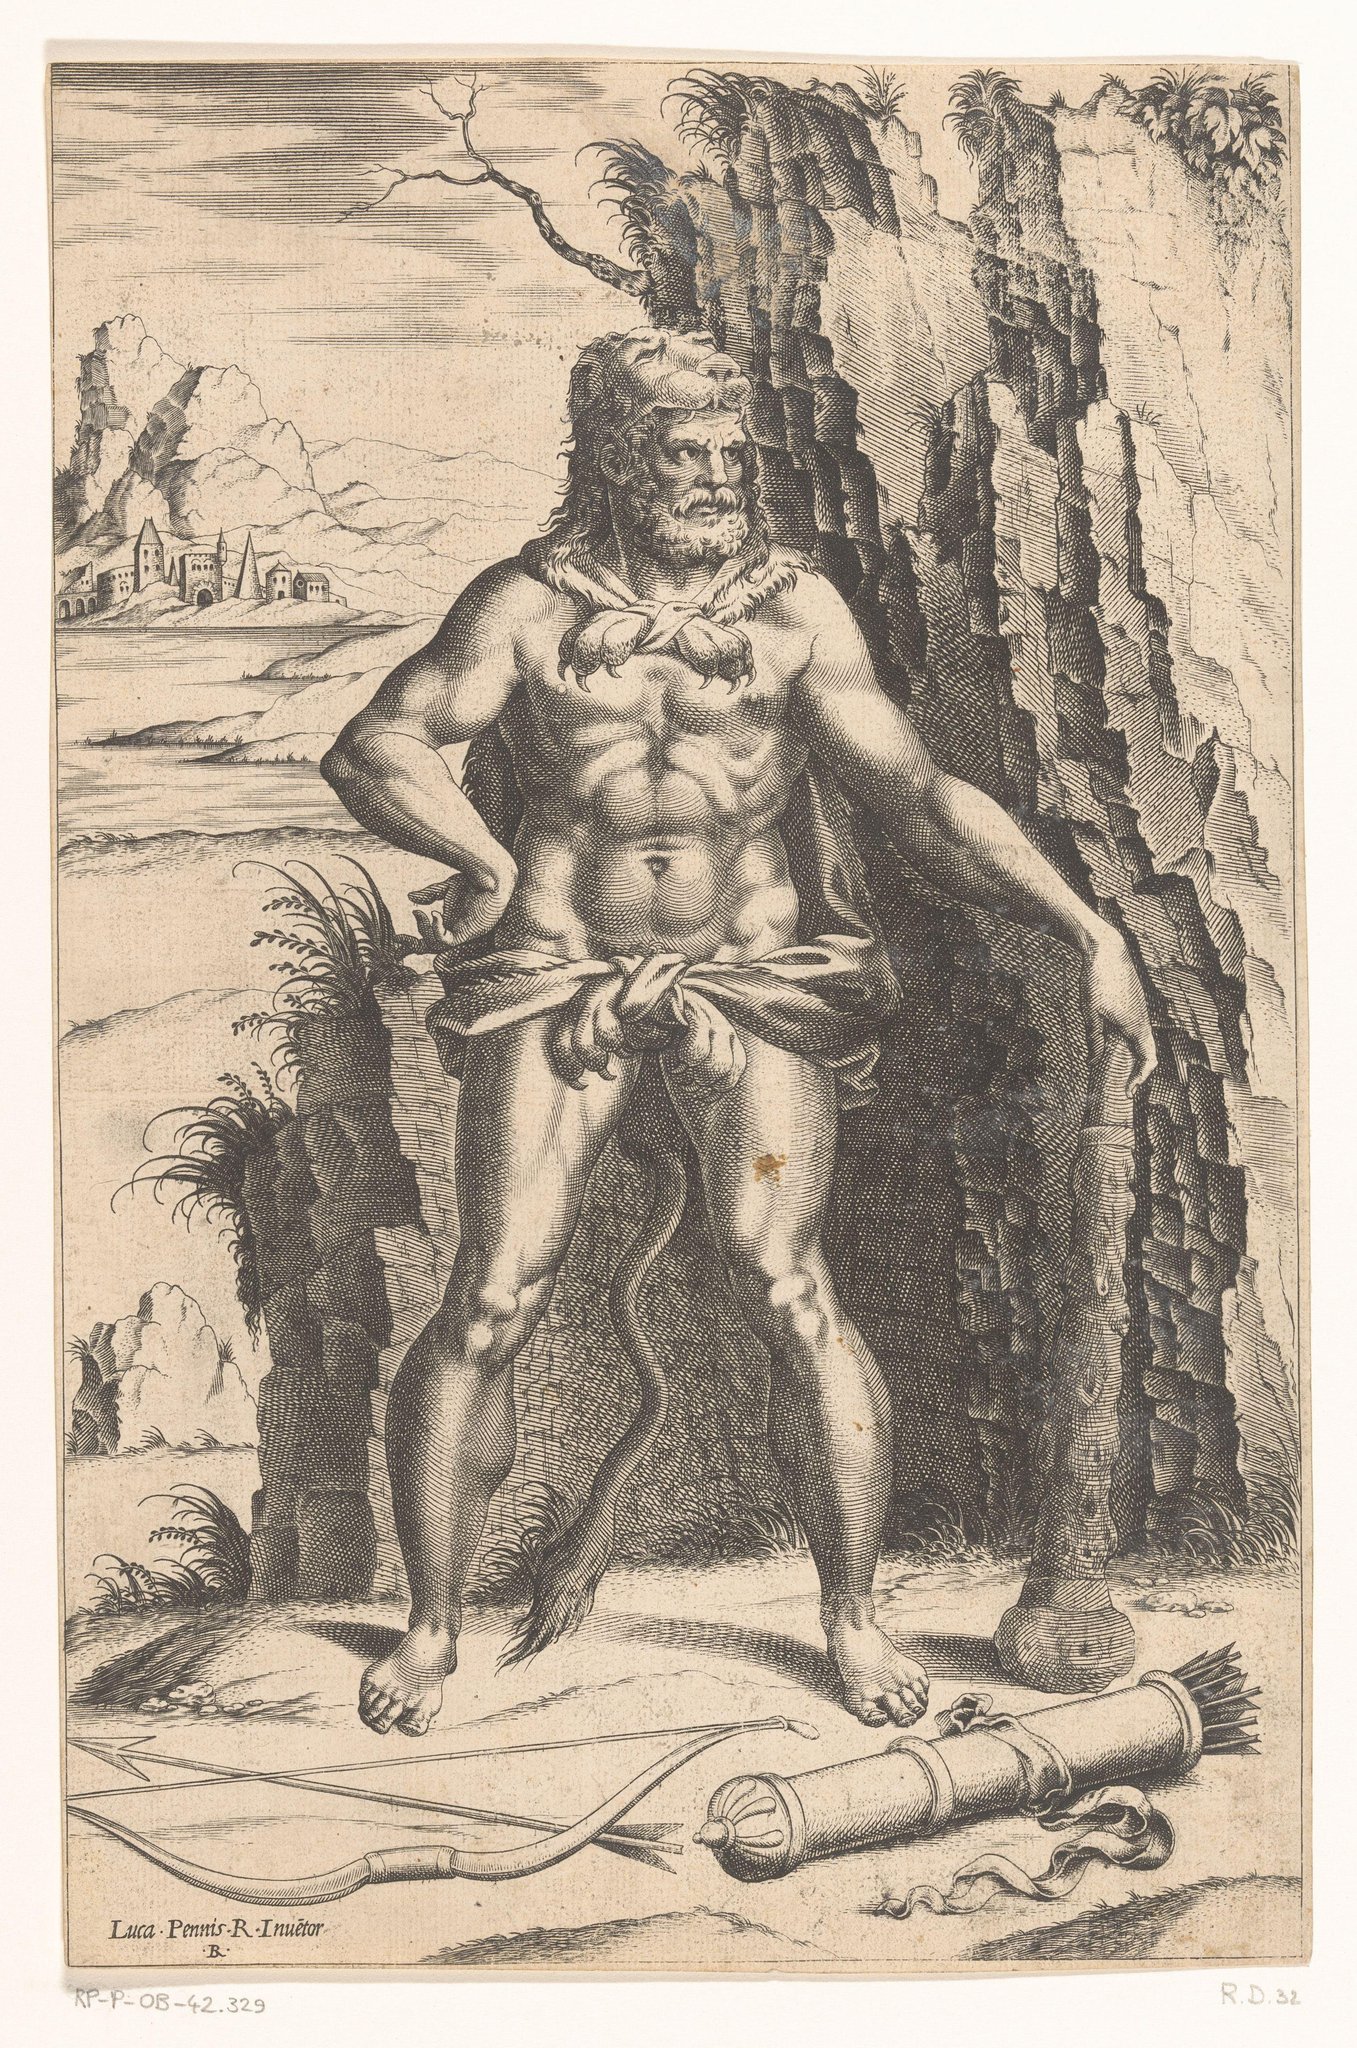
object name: print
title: Hercules in een landschap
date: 1535-1598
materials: paper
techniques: engraving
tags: (story of) hercules (heracles), attributes of hercules (with name)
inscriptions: collector's mark: Lugt 240